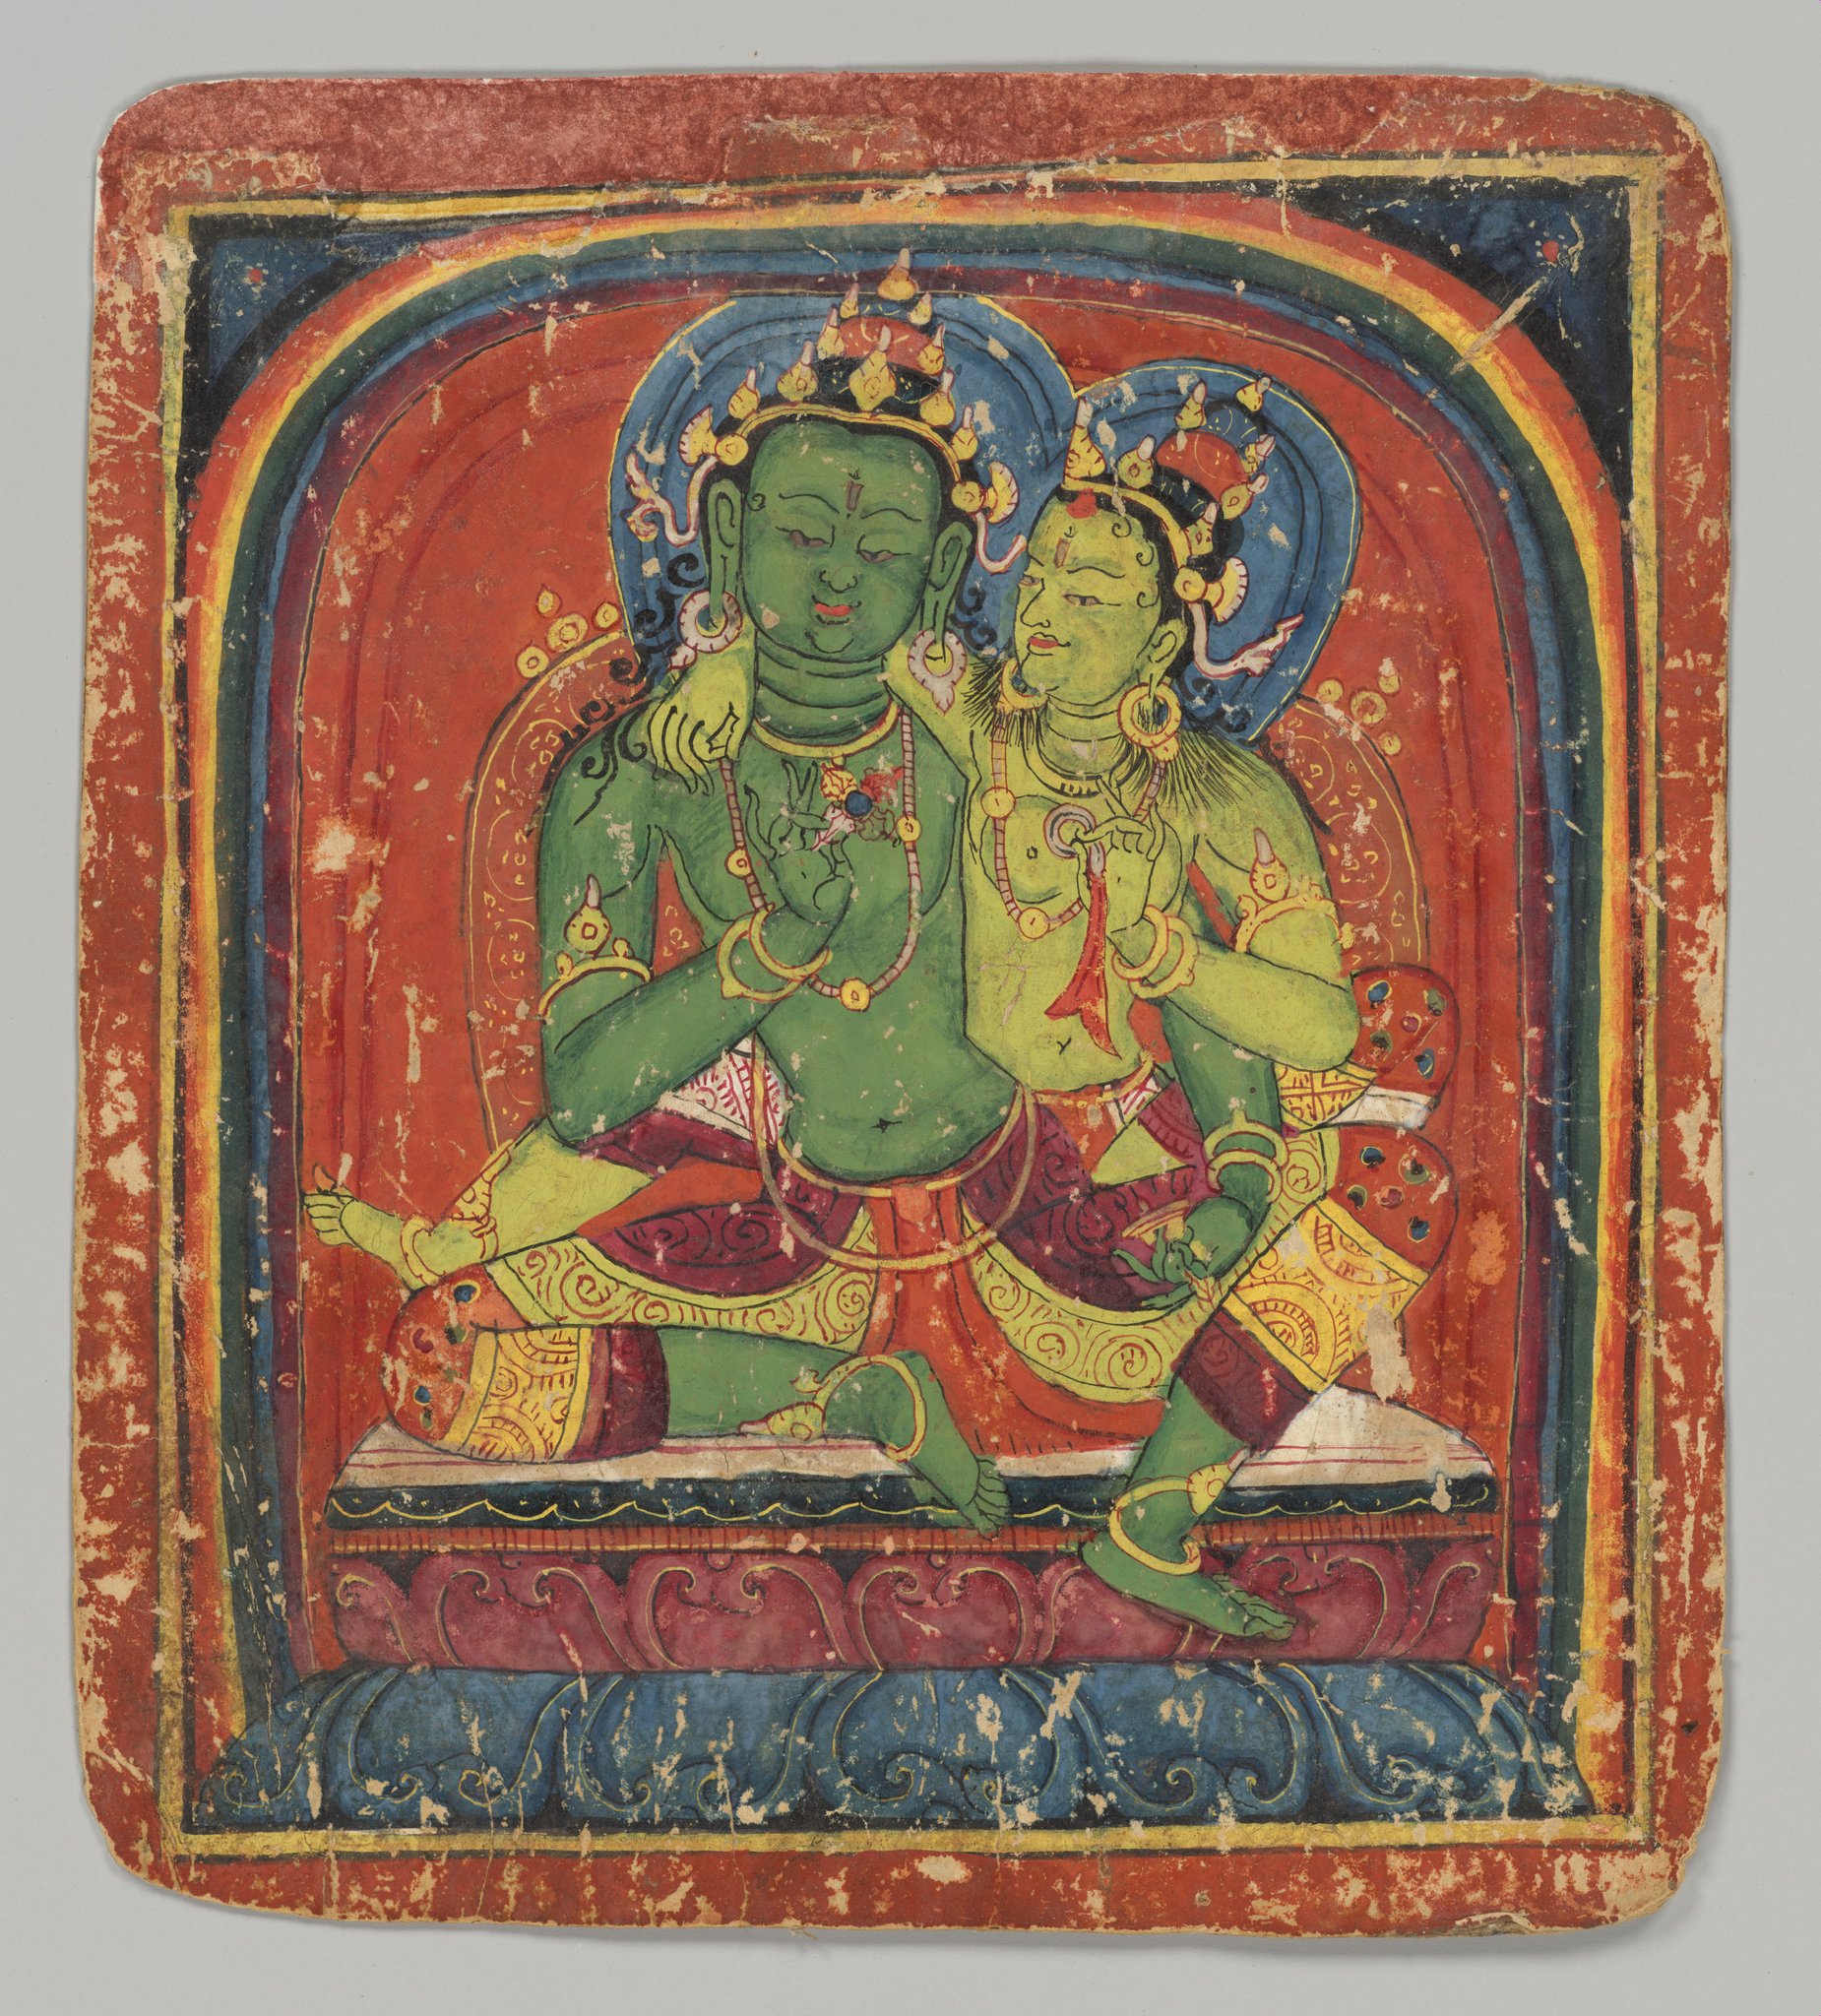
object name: initiation card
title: Initiation Card (Tsakalis): Vajrapani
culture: tibetan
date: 1401-1433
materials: paper, watercolor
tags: buddhism,bodhisattvas